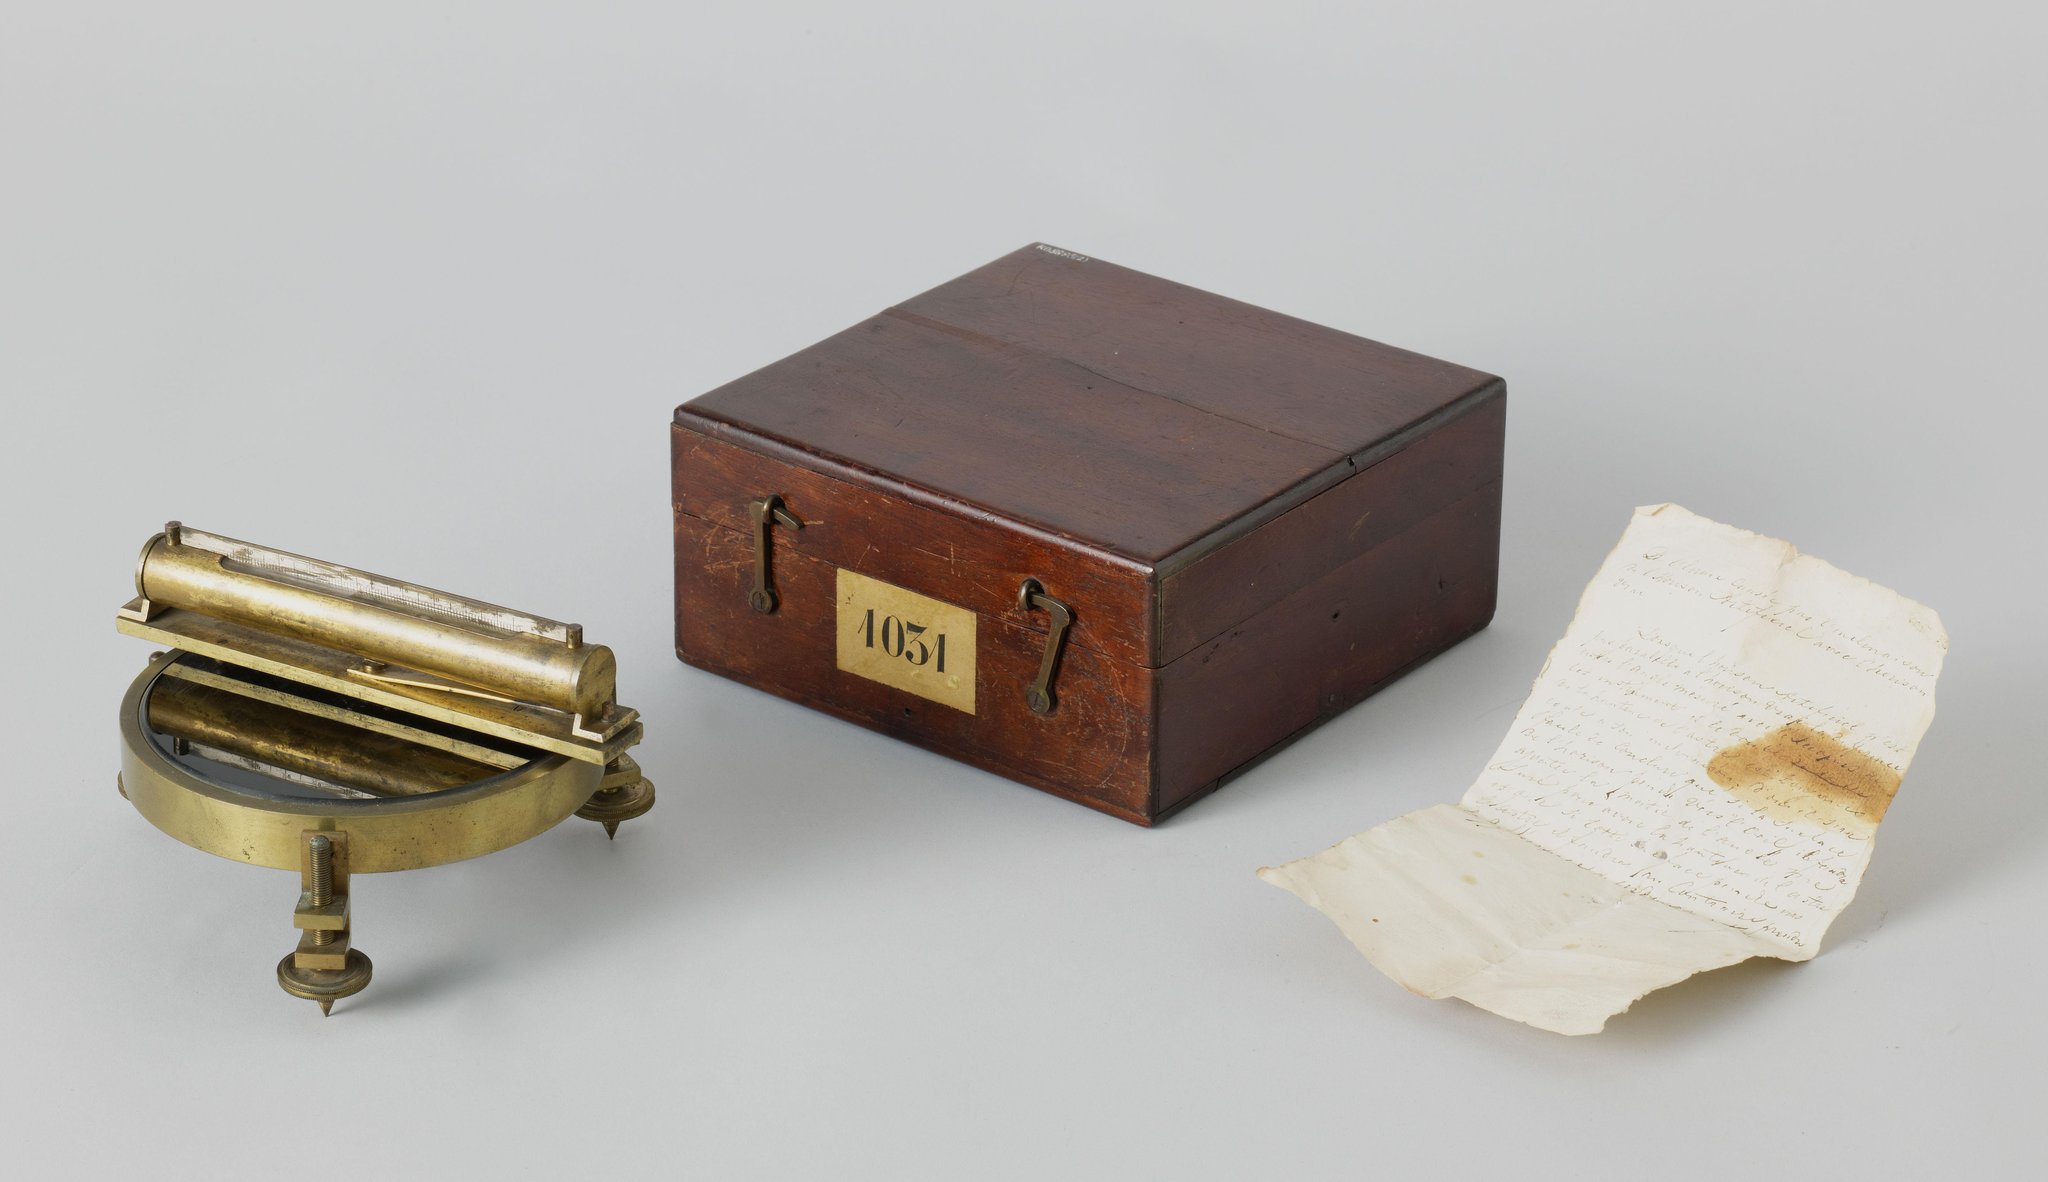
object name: measuring instrument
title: Artificial Horizon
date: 1830-1865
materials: brass, textile, glass, iron, lead, paper, liquid, wood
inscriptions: label, on the box: ‘1031’ former inventory label, inscription, on a note, handwritten: ‘De l'Erreur Causée par l'inclinaison / de l'Horison Artificiel avec l'horizon / vrai / [followed by description]’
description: Artificiële horizonten worden gebruikt om de hoogte van een hemellichaam met een octant of sextant te meten als de natuurlijke horizon niet waargenomen kan worden. Deze artificiële horizon was een geschenk van A. Klerck. Het lijkt erg veel op het instrument van Wegener uit Berlijn, zoals beschreven door Kaiser in 1883. In de eerste decennia van de tweede helft van de 19de eeuw gaf de Nederlandse Marine de voorkeur aan kwik-horizonten.